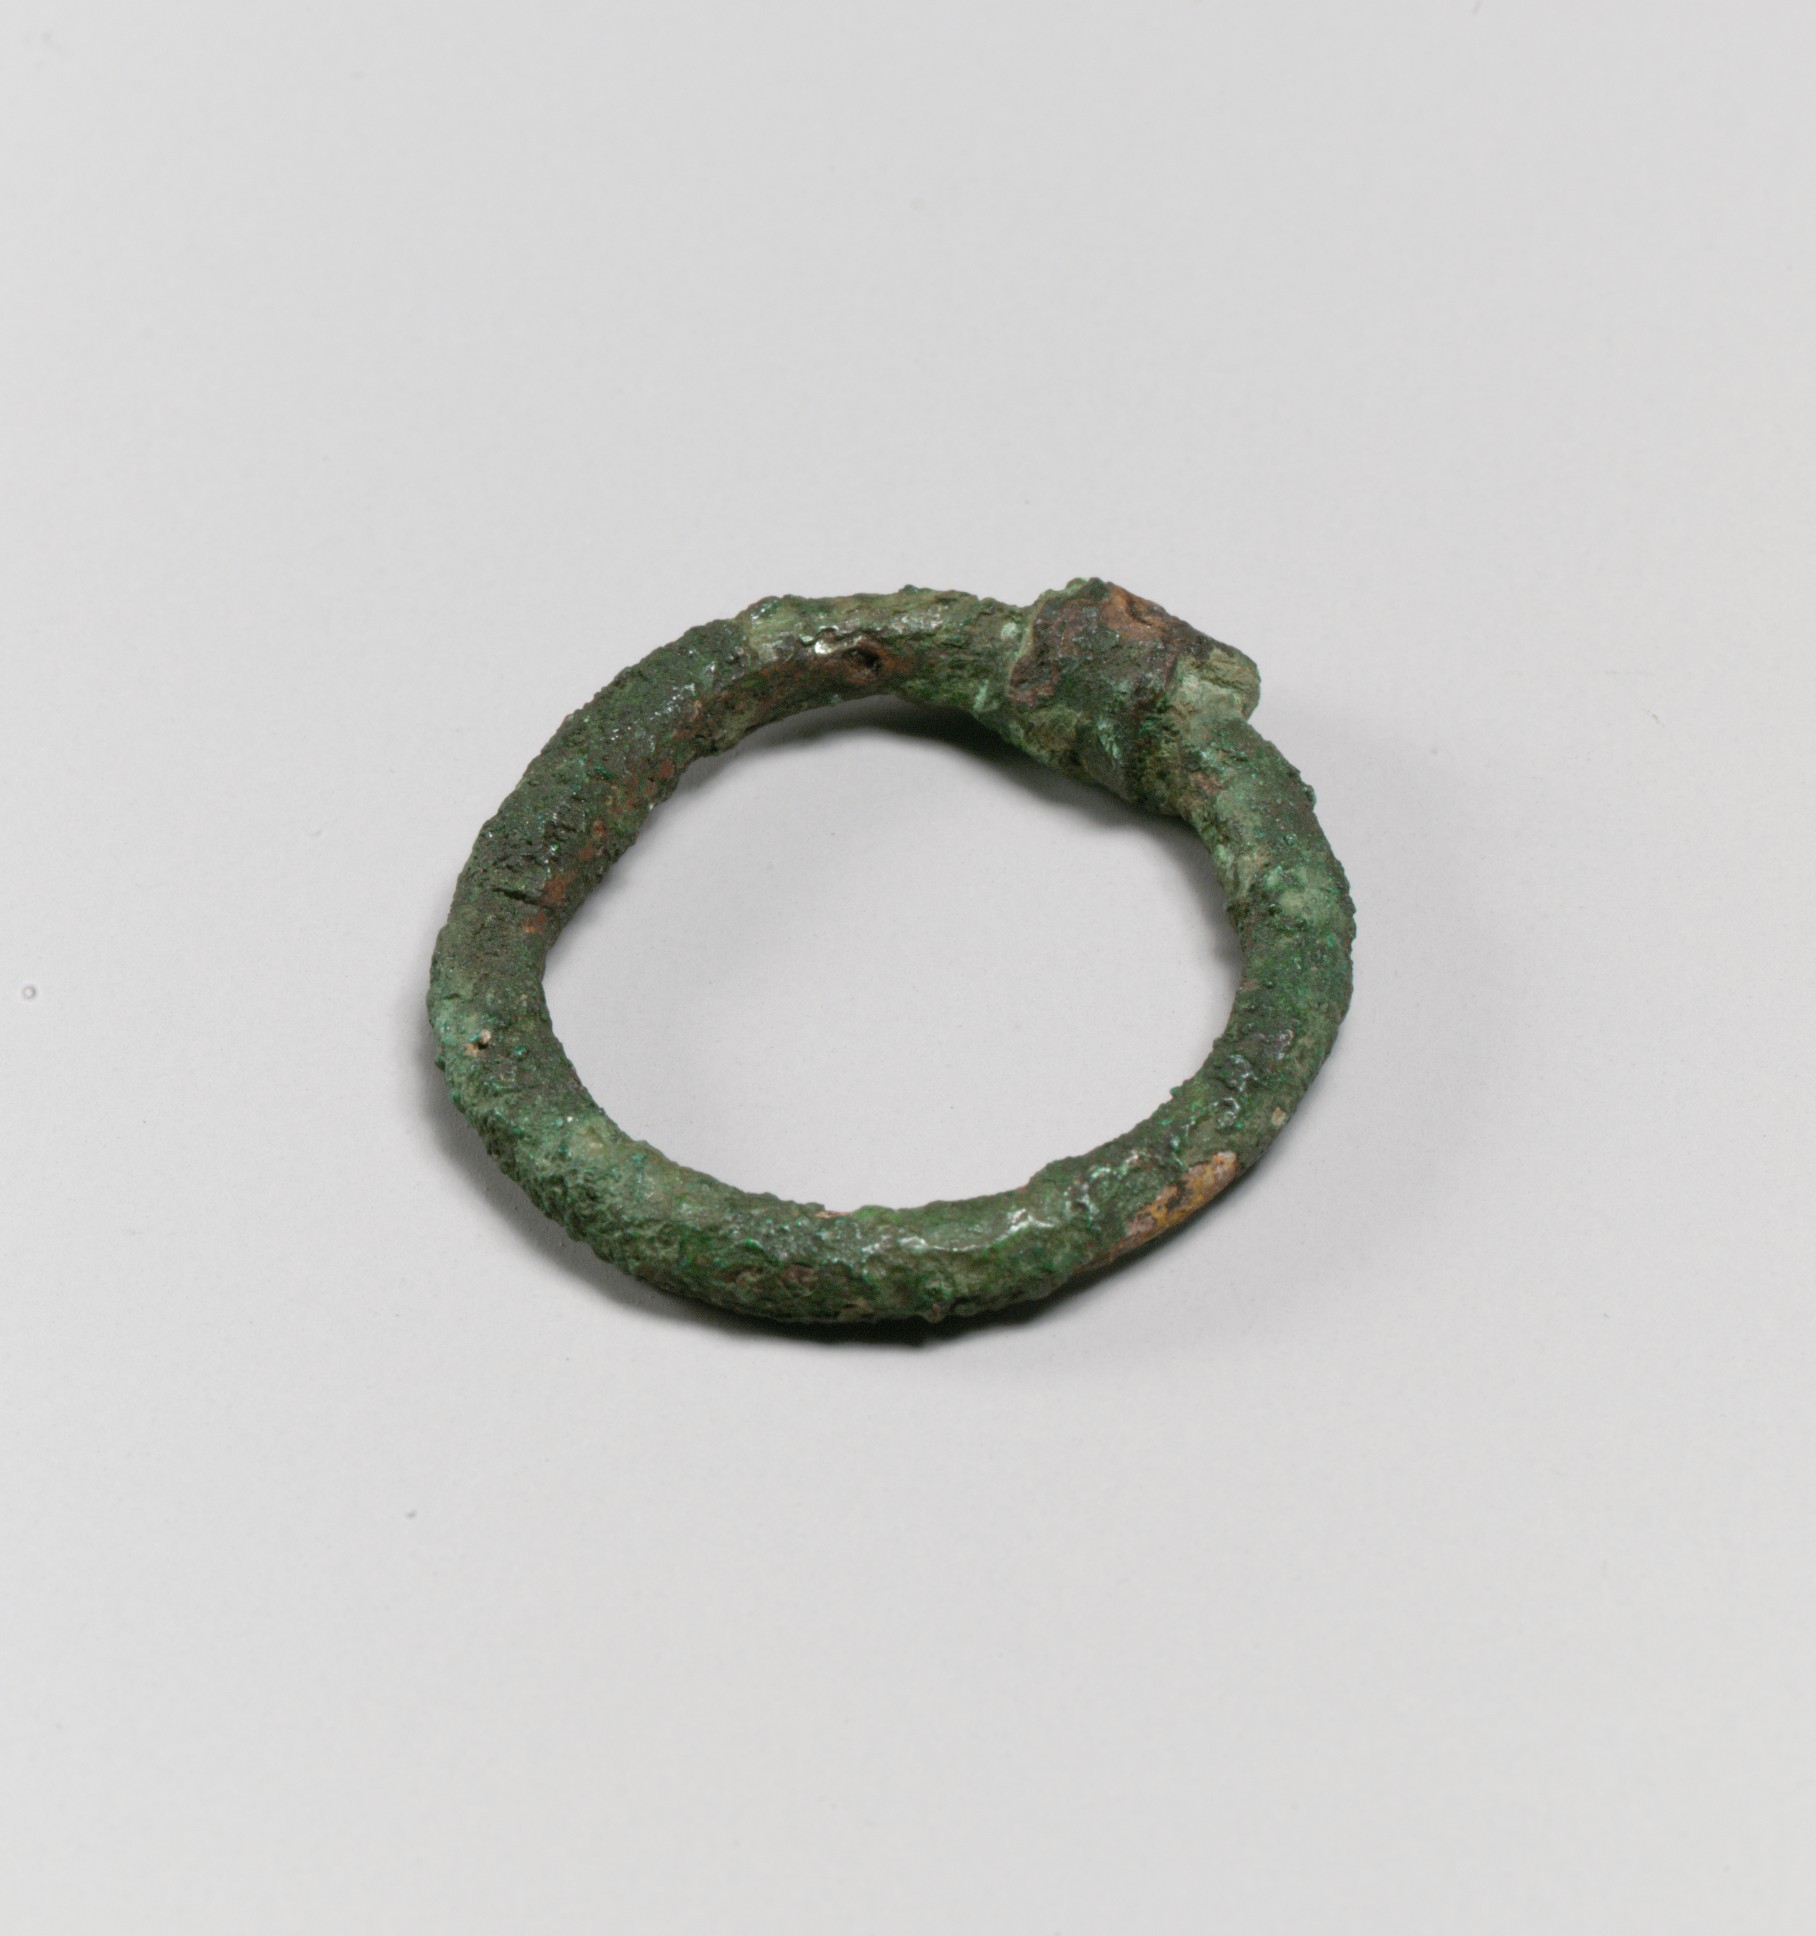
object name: buckle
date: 7000 BCE-330 CE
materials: bronze